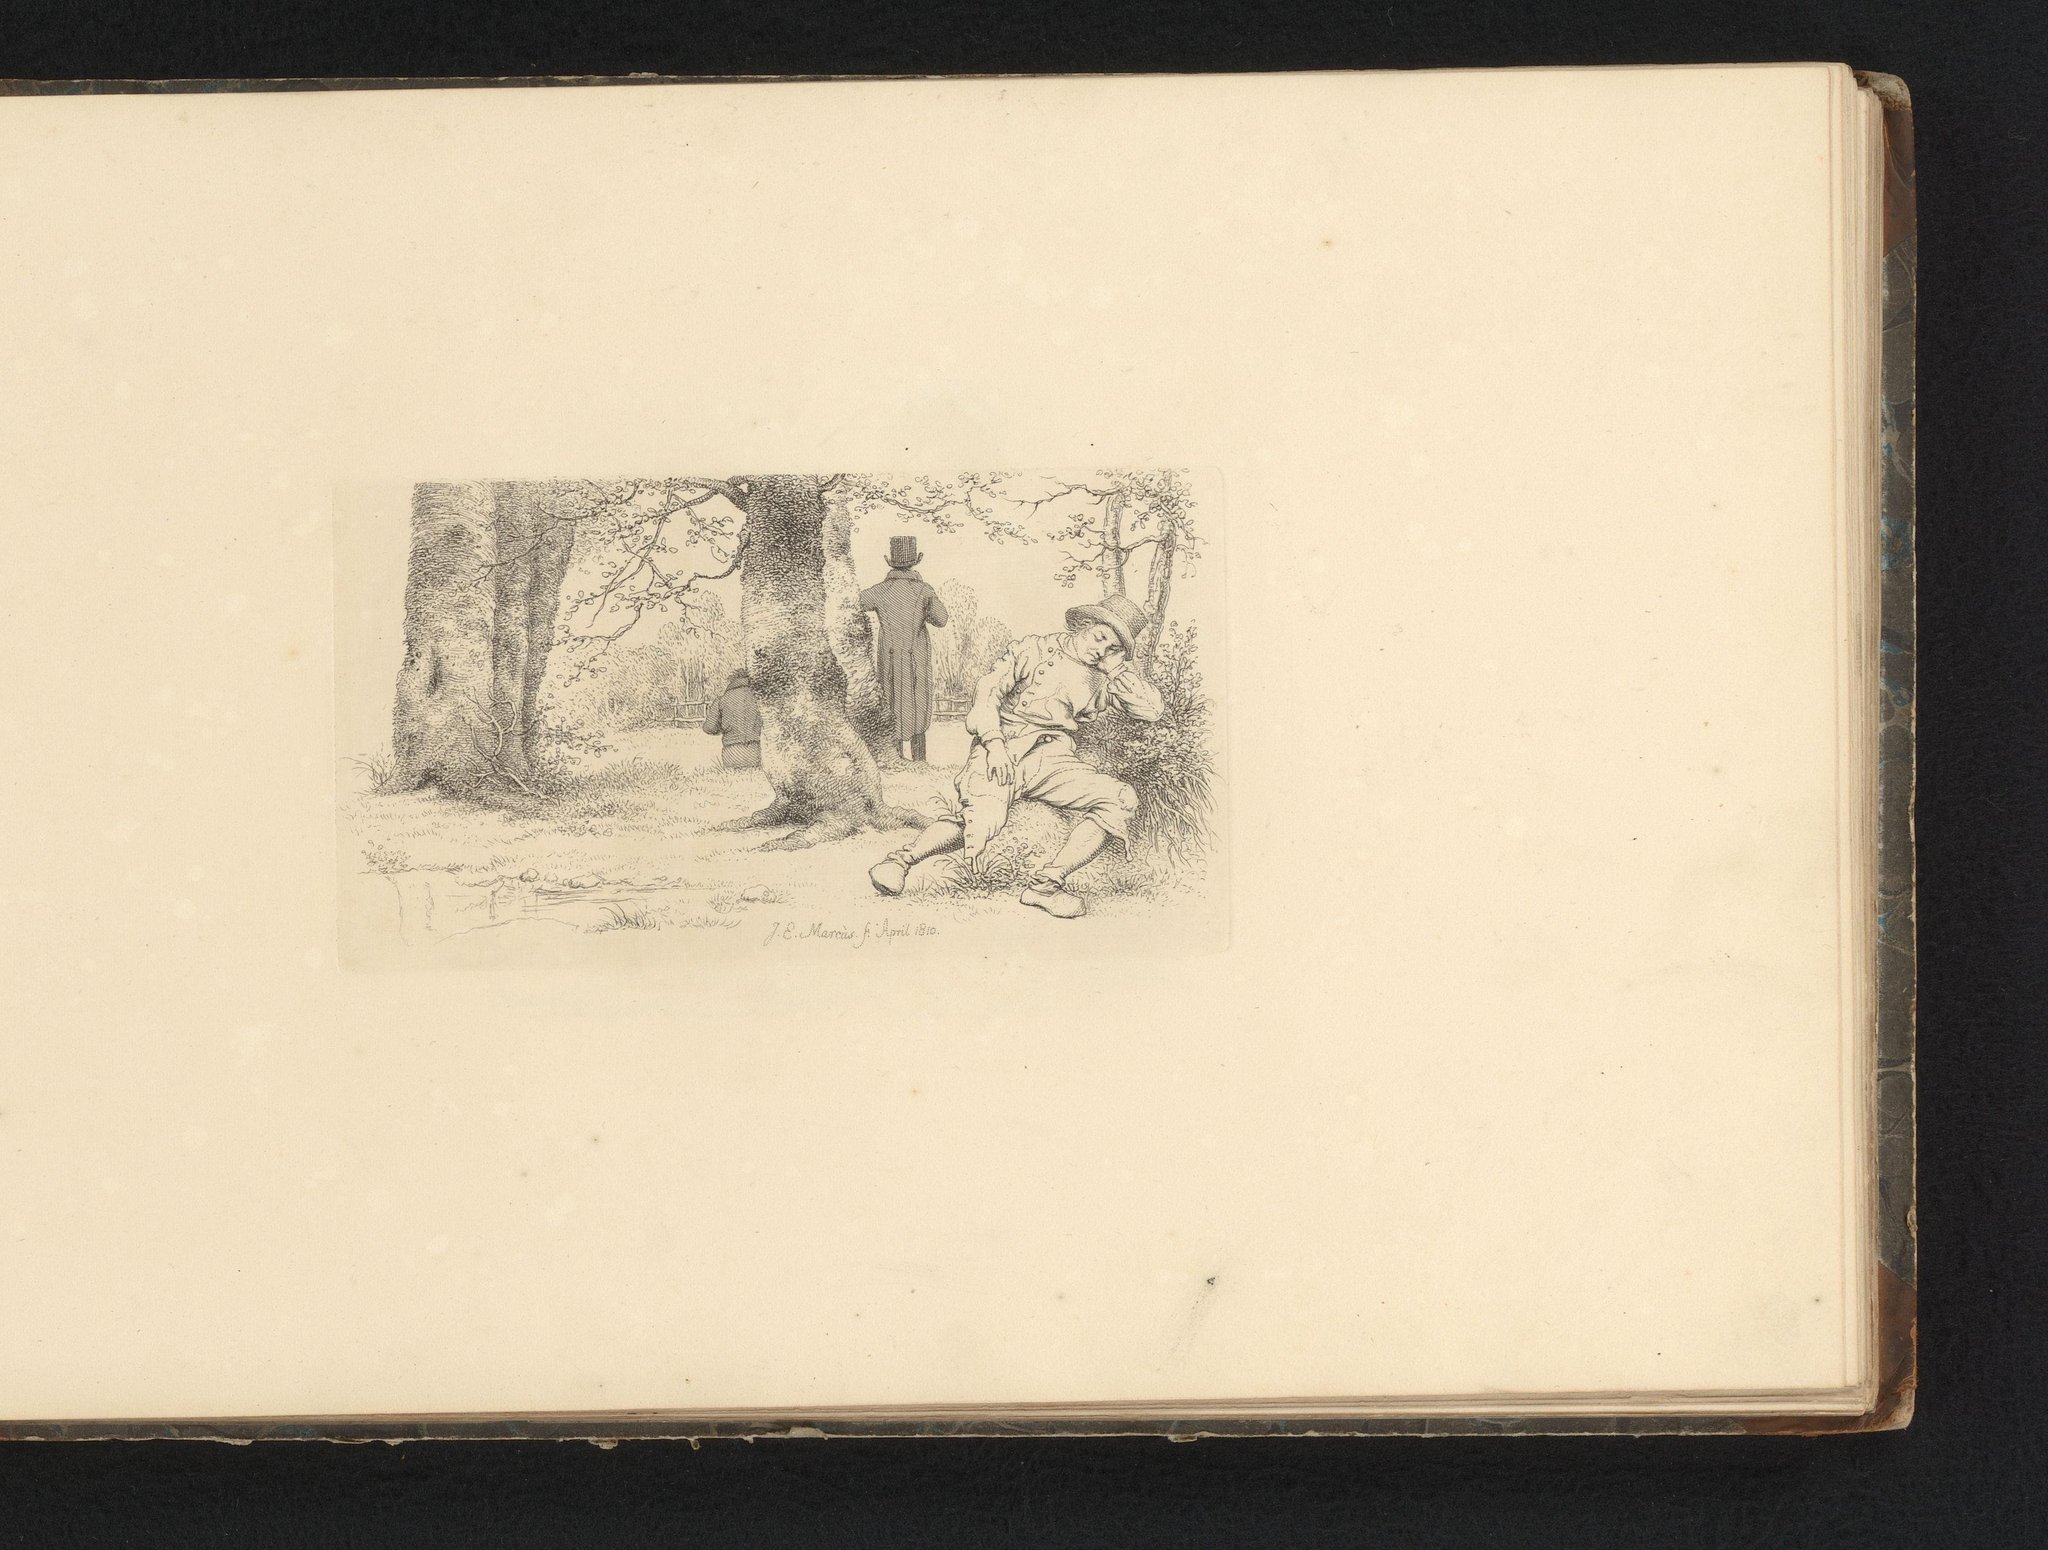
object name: print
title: Studiebeelden en fragmenten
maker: jacob ernst marcus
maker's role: draughtsman, print maker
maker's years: 1774-1826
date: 1804-1810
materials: paper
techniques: etching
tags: adult man, sleeping on the ground - bb - out of doors, wood and park (as places of recreation)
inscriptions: date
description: Deze prent maakt deel uit van een album.